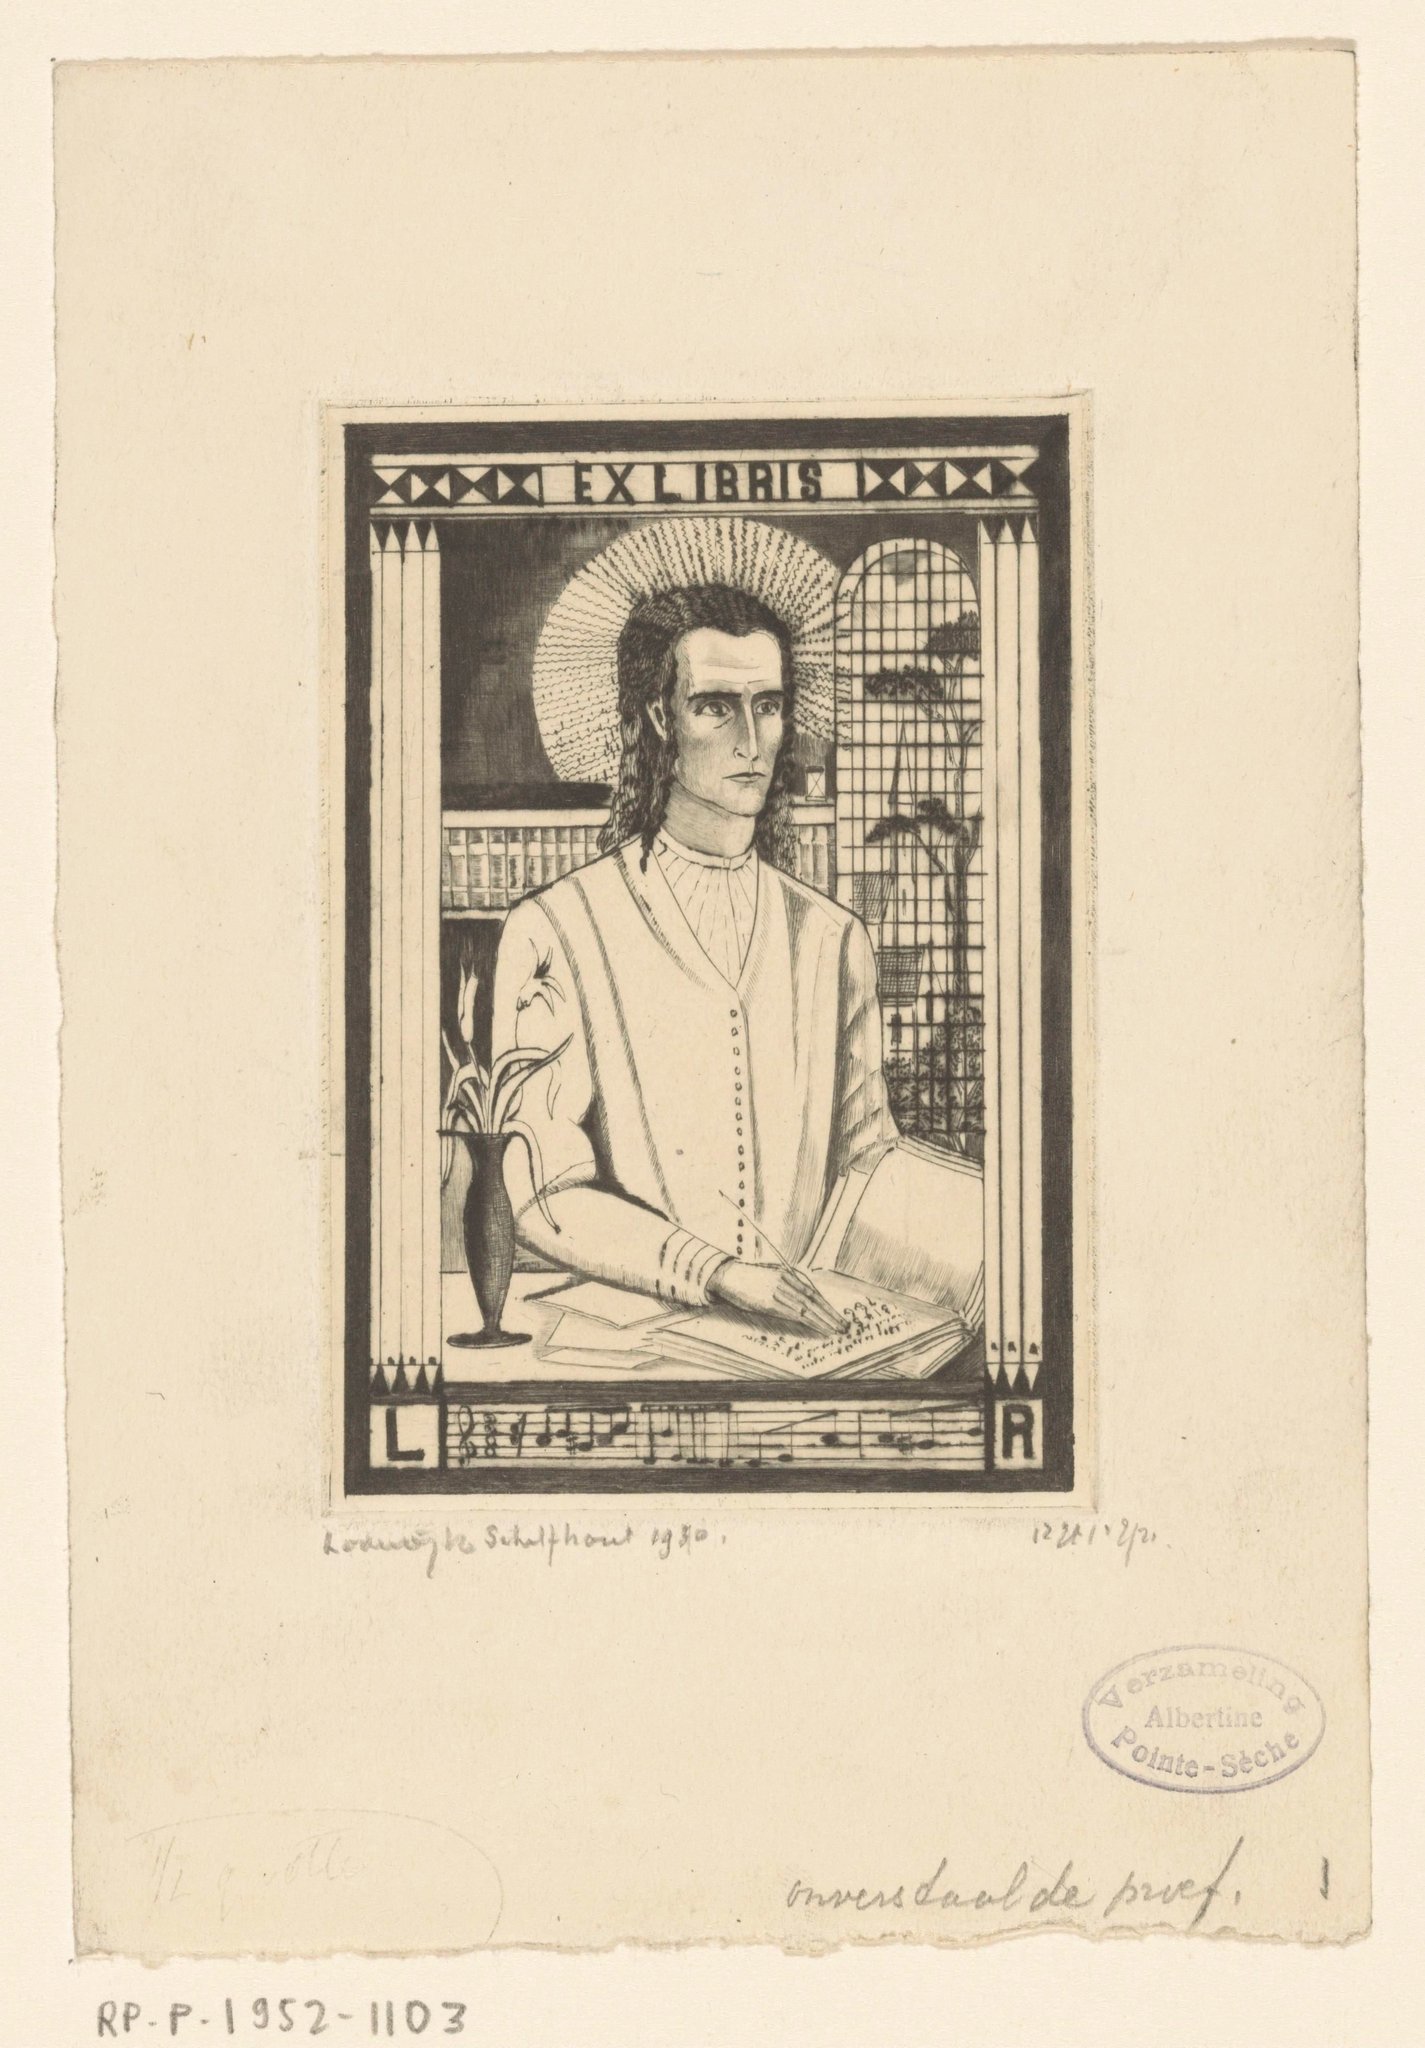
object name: bookplate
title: Ex libris van L. Ramondt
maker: lodewijk schelfhout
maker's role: draughtsman, print maker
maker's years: 1881-1943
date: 1930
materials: paper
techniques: drypoint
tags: nimbus, halo ~ radiance emanating from persons or things, notation of music, writing and letters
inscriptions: collector's mark: Lugt 5i, inscription: ‘onverstaalde proef.’, collector's mark: Lugt 2760, collector's mark: Lugt 2228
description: Een man met aureool schrijft in een boek. Onder het geheel een notenbalk.